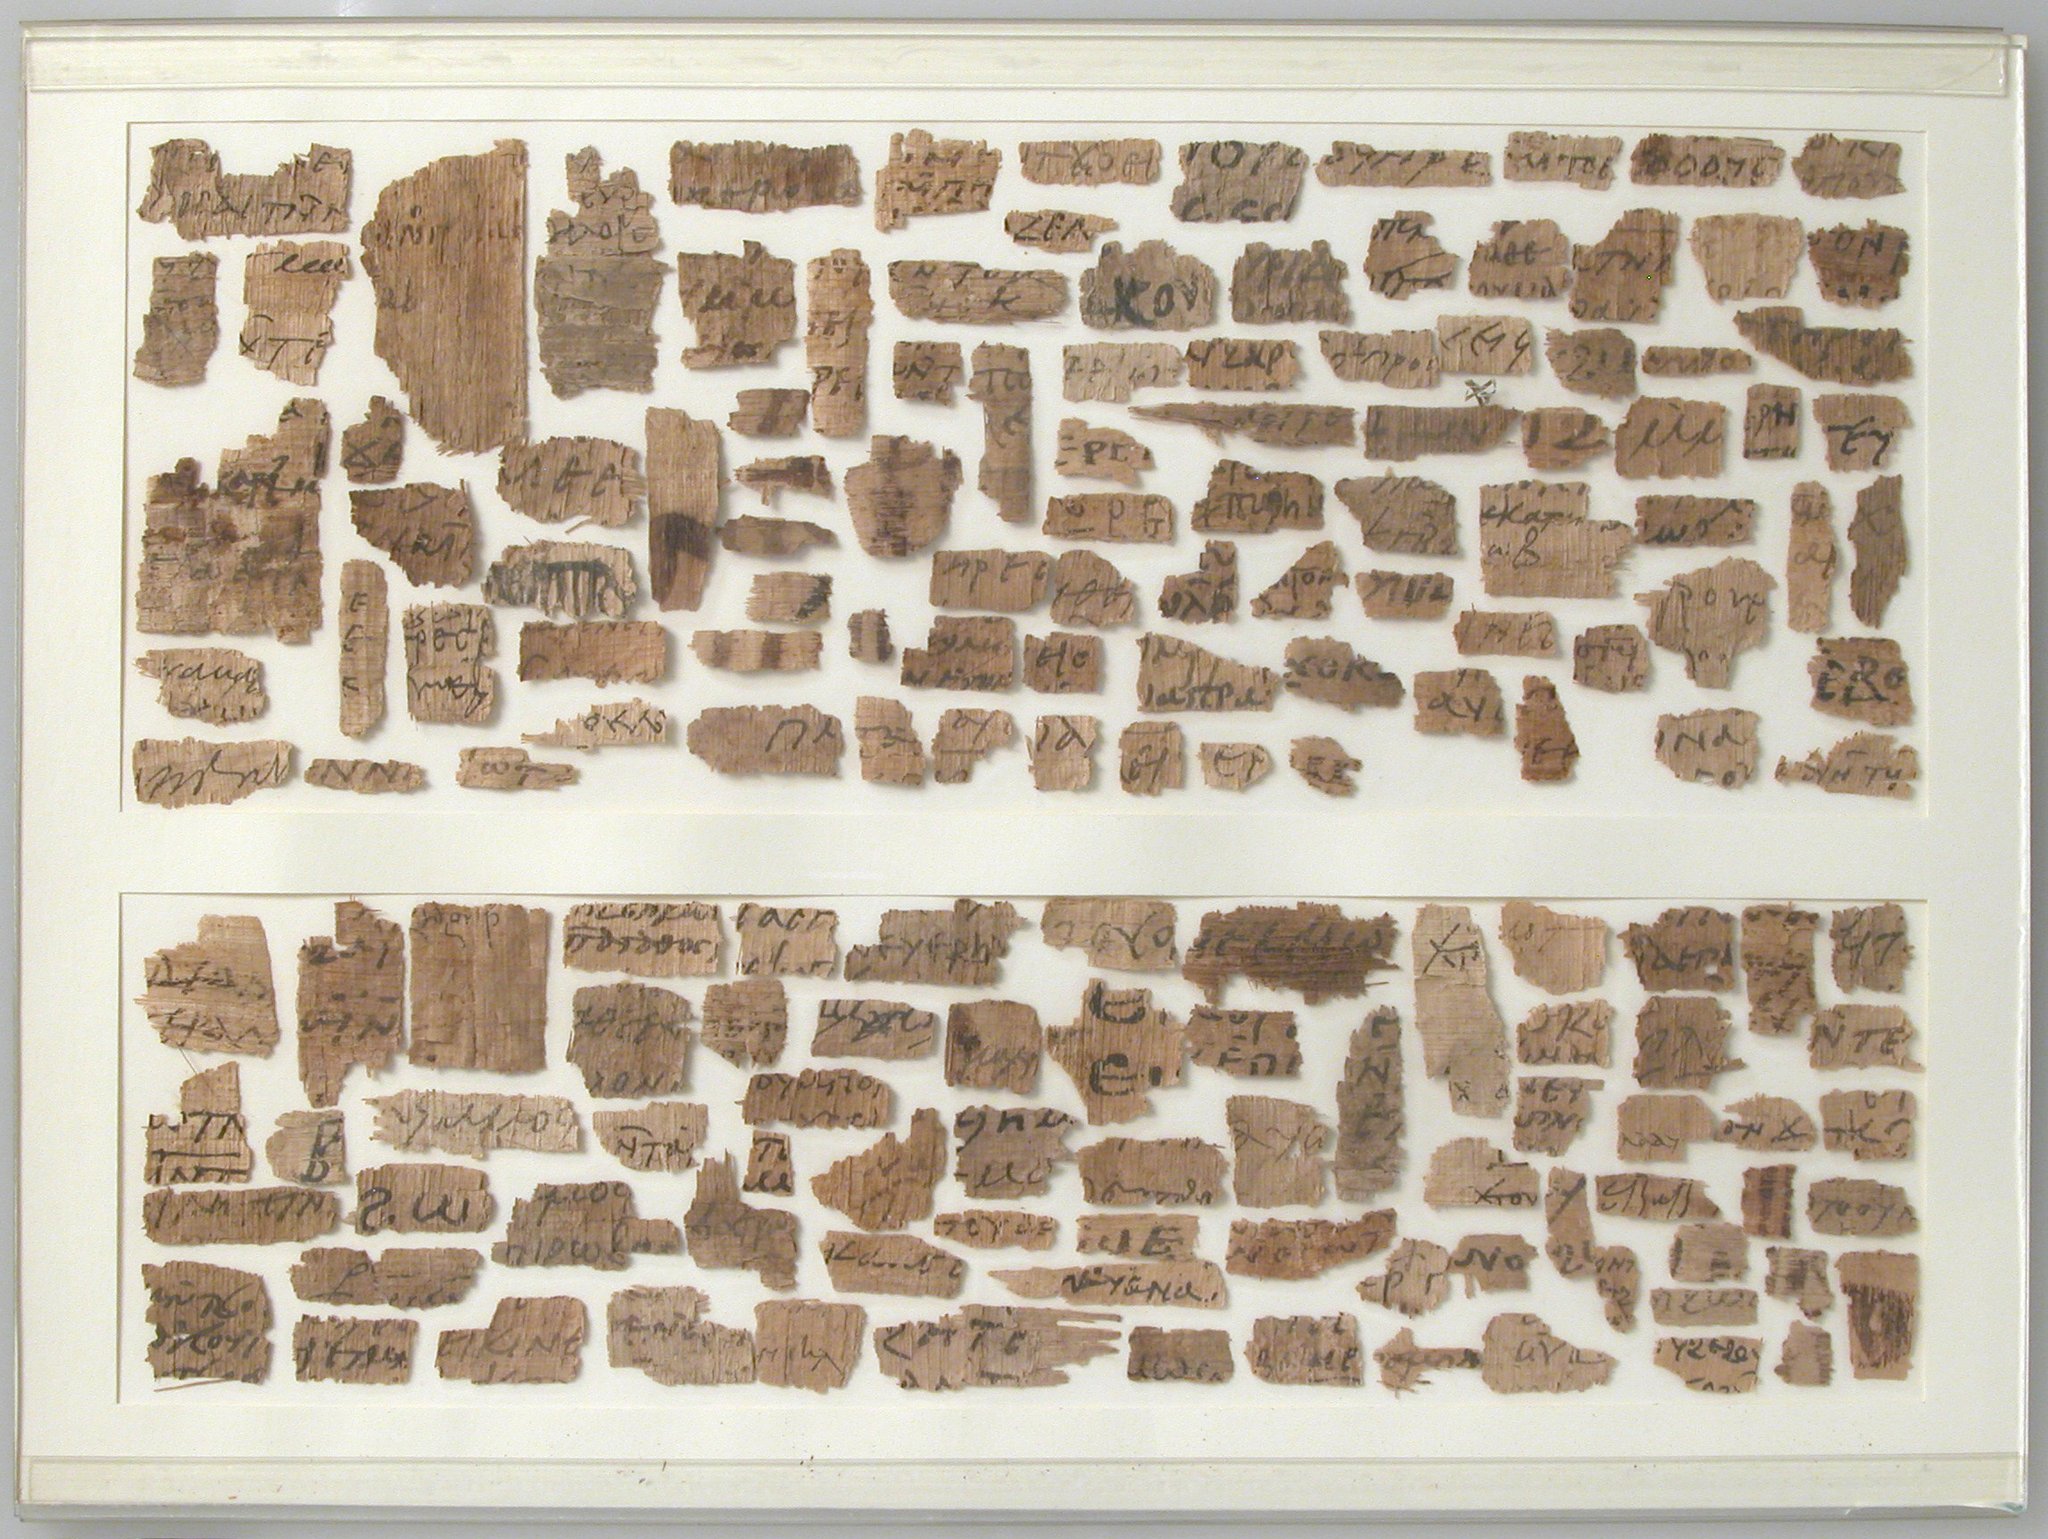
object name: fragment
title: Papyri Fragments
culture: coptic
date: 601-700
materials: ink, papyrus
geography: egypt